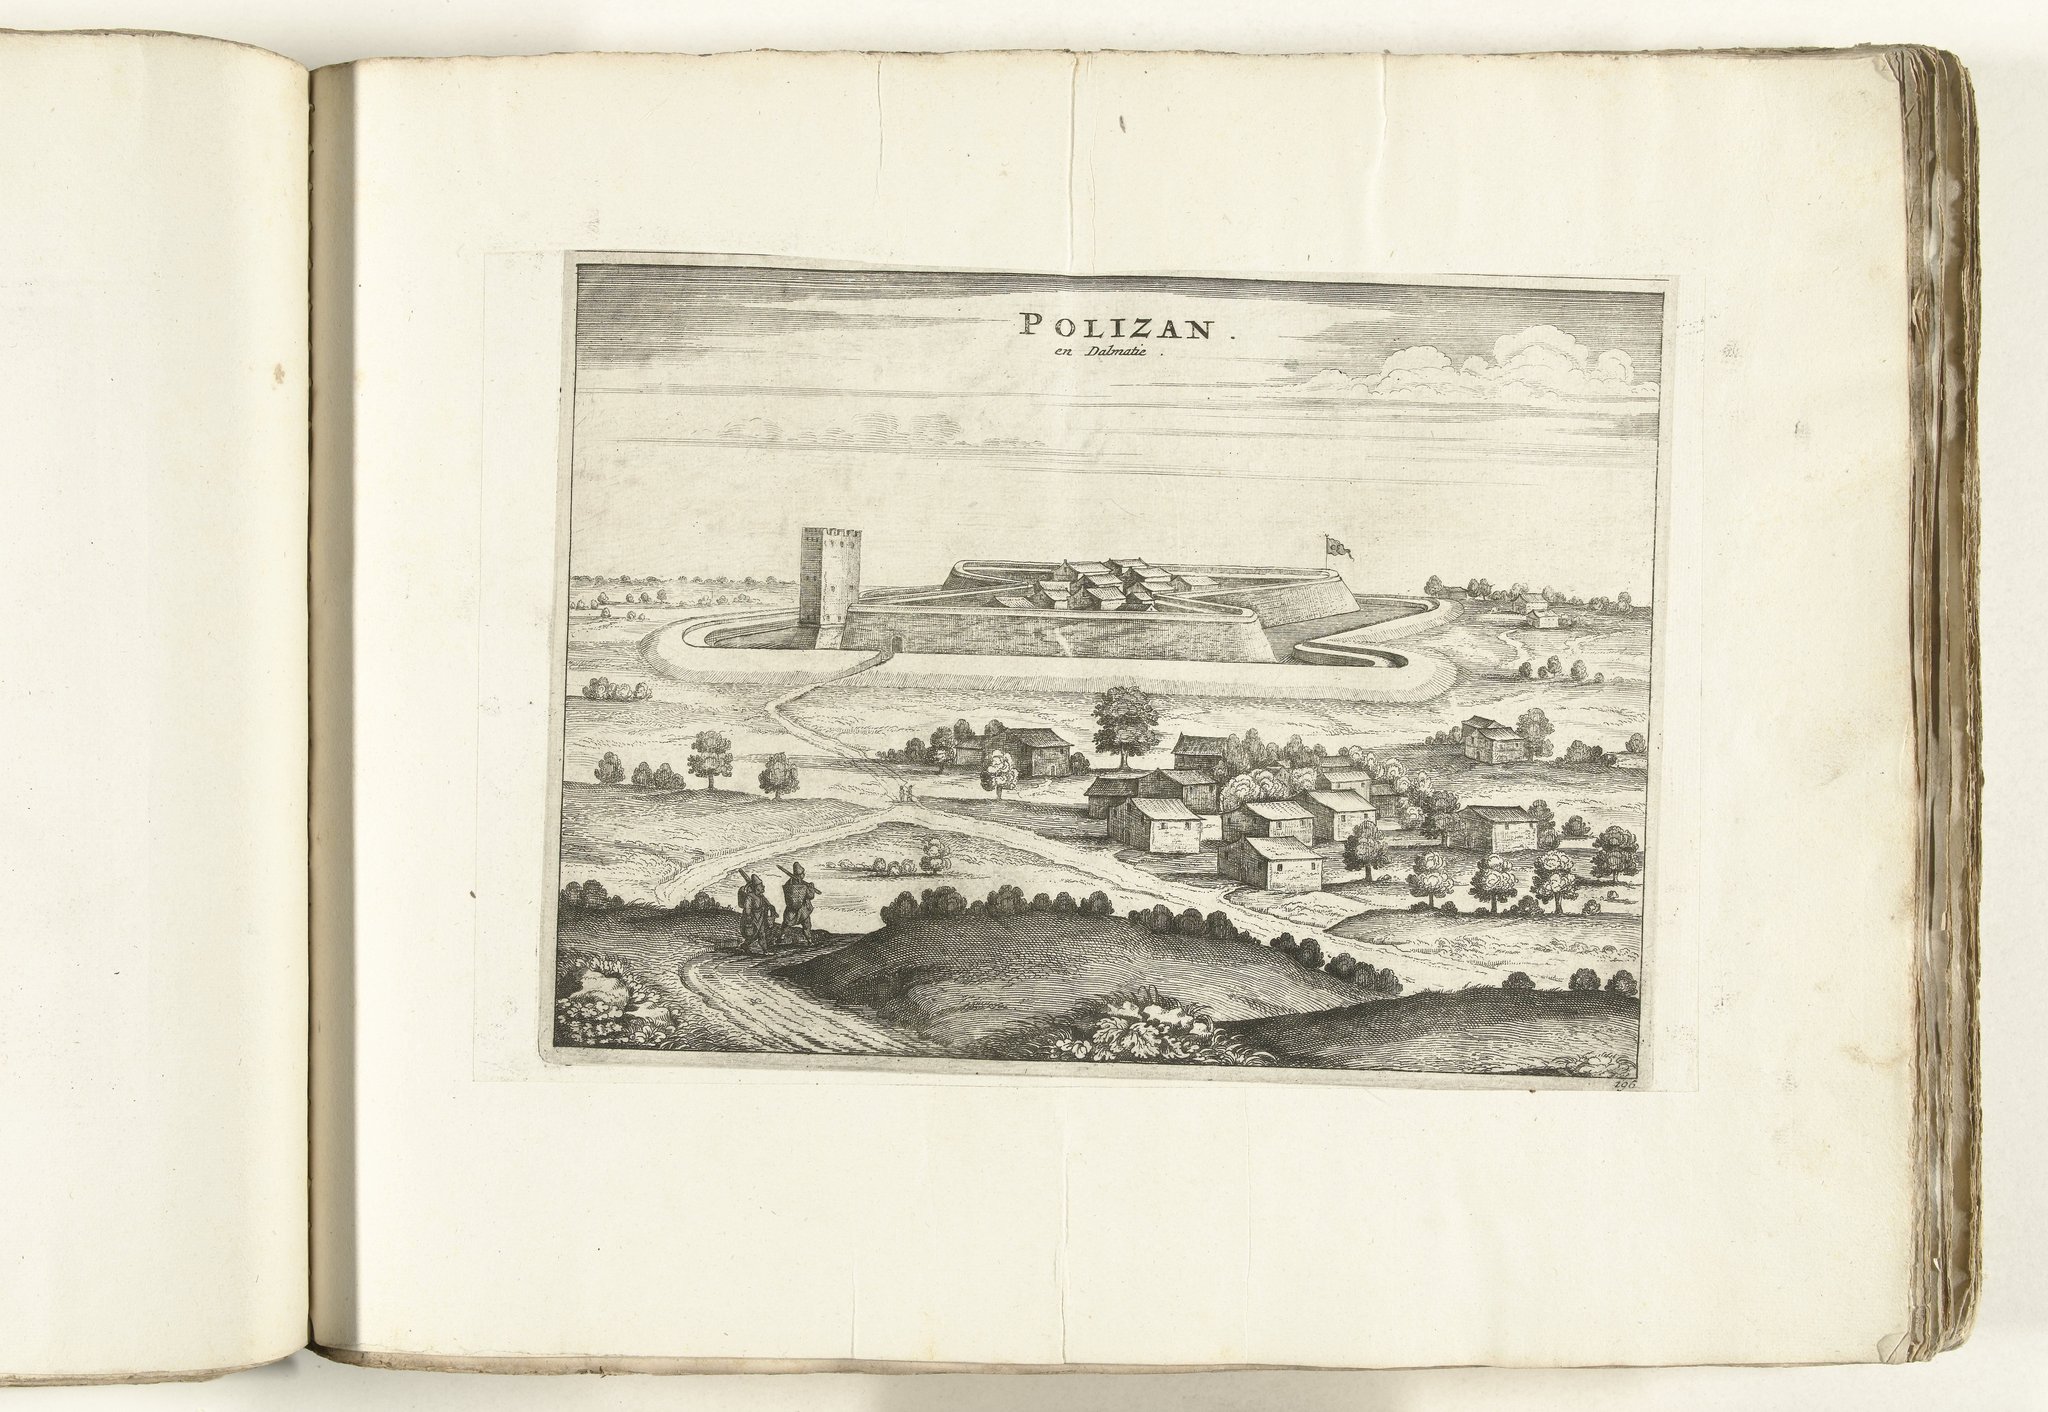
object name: print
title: Polizan en Dalmatie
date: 1702-1703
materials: paper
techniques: etching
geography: northern netherlands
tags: fortress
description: Gezicht op de vesting van Polizan in Dalmatië (Kroatië). Plaat nr. 196 in het prentwerk bestaande in totaal uit 276 genummerde platen van vermaarde sterke steden en vestingen in het kader van de Spaanse Successieoorlog. Voor het merendeel zijn deze platen gekopieerd naar de anonieme Franse platen: in Les forces de l'Europe en in: Le theatre de la guerre, dans les Pays-Bas, beide oorspronkelijk uitgegeven door Nicolas de Fer te Parijs (1693-1697) in het kader van de Negenjarige Oorlog. Titel en opschriften in de plaat in het Frans. Blad uitgeknipt en opgeplakt.